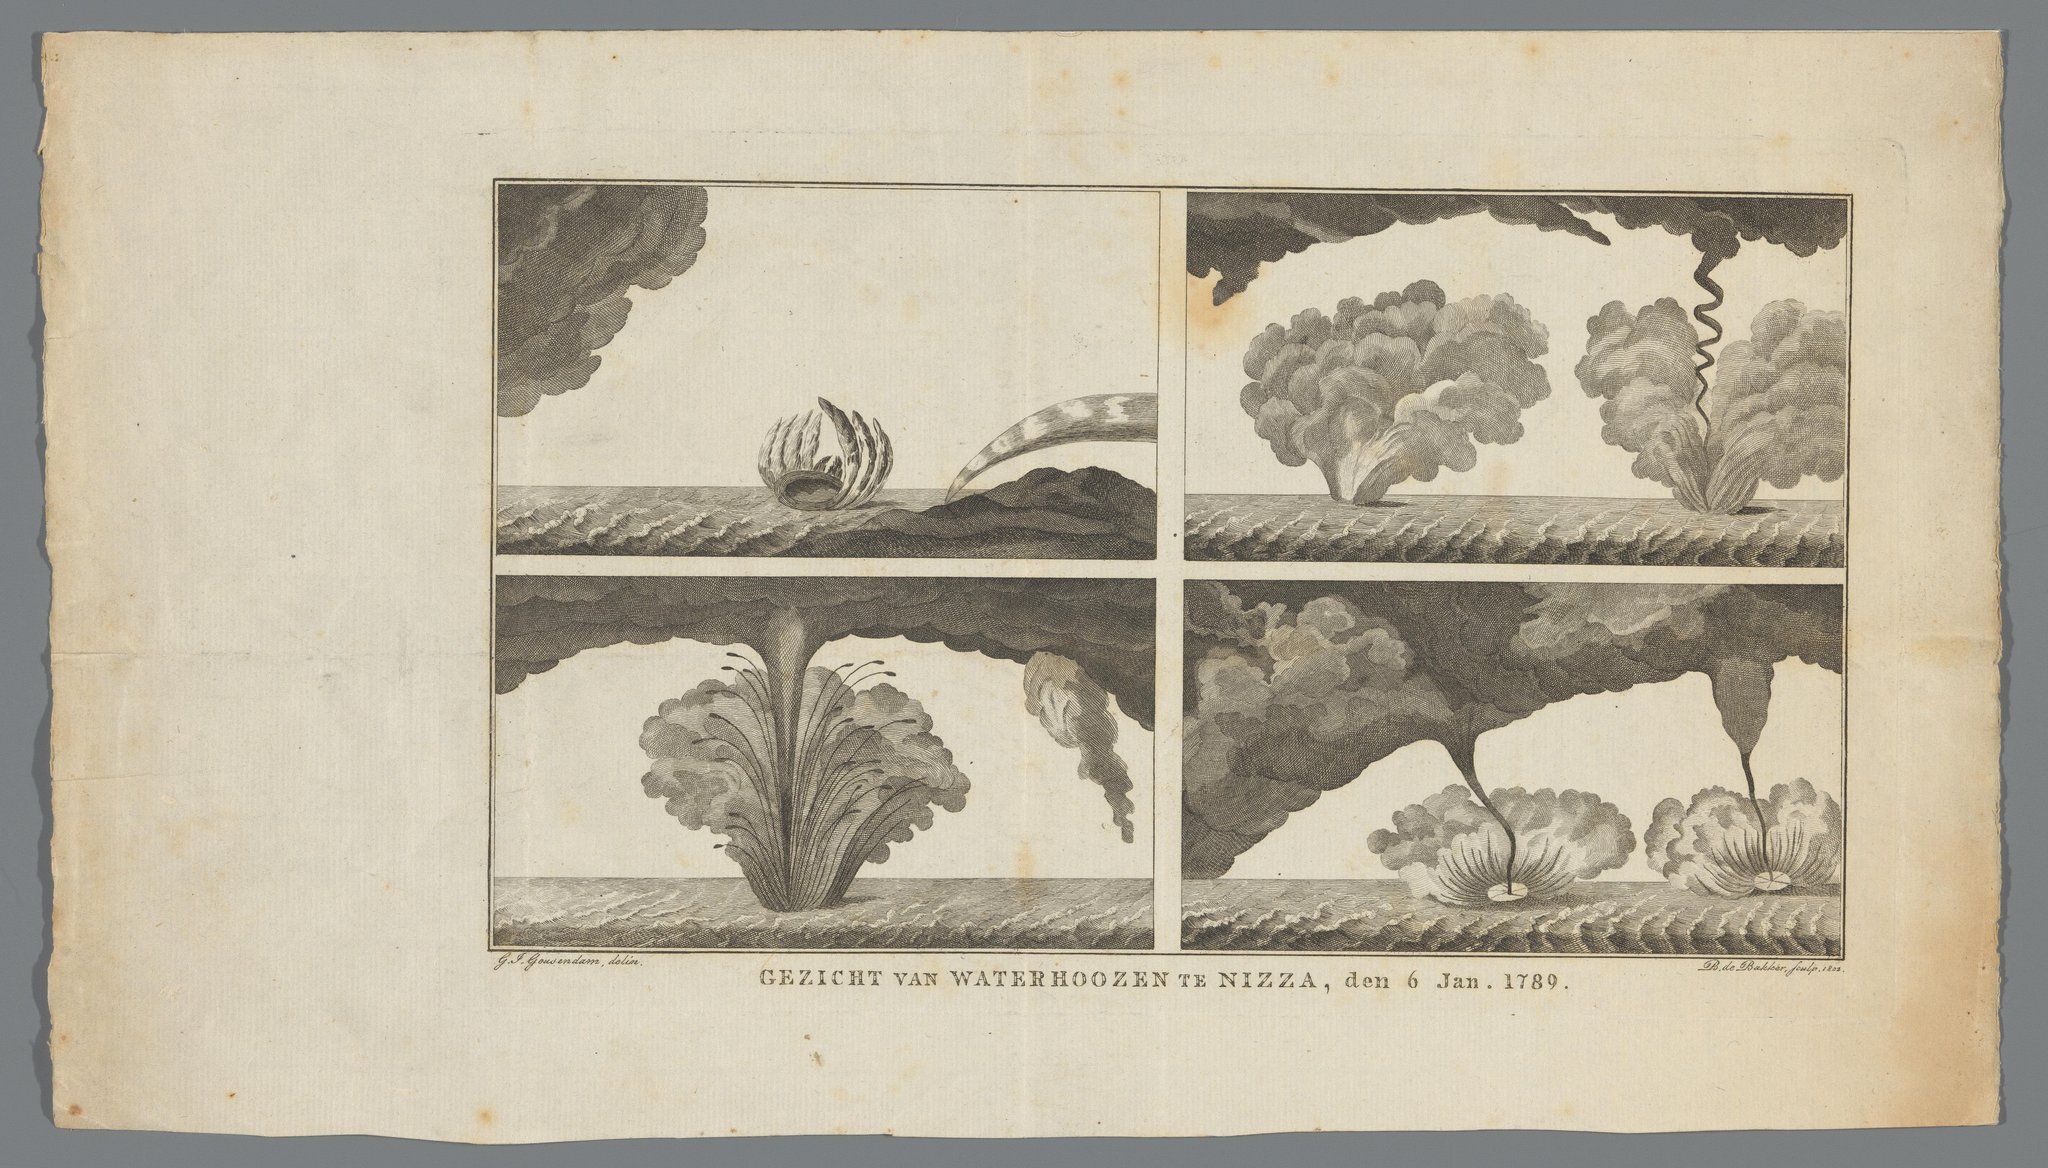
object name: print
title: Waterhozen bij Nice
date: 1802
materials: paper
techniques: etching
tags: whirlwind, cyclone, hurricane, typhoon, tornado at sea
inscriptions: collector's mark: Lugt 2228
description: Blad met vier voorstellingen van waterhozen bij Nice op 6 januari 1789.